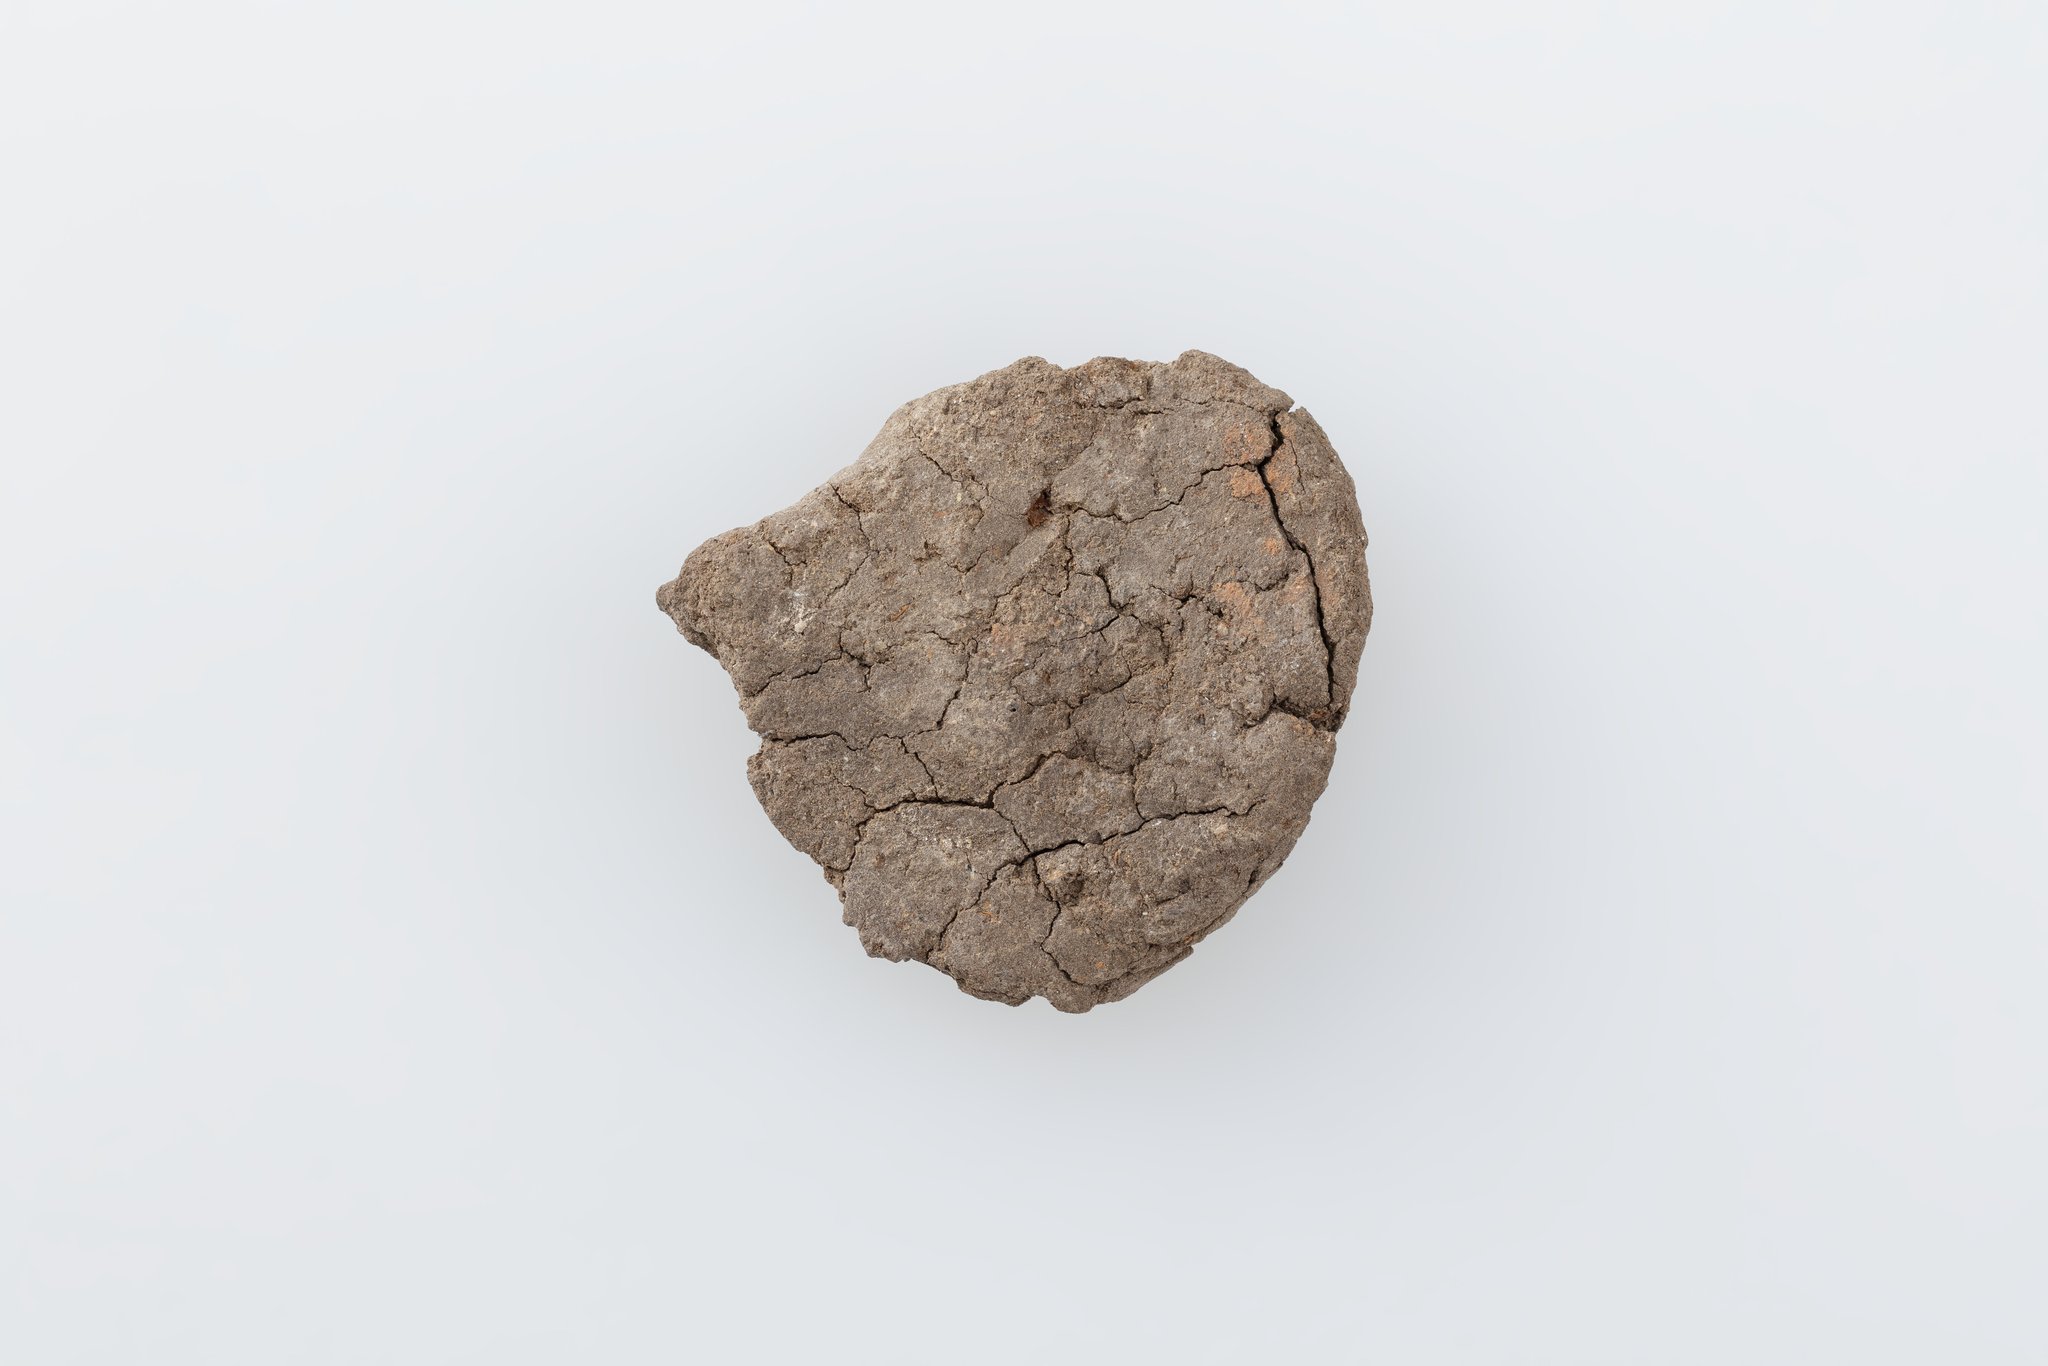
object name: model food offering, cake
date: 1981-1975 BCE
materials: mud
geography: egypt